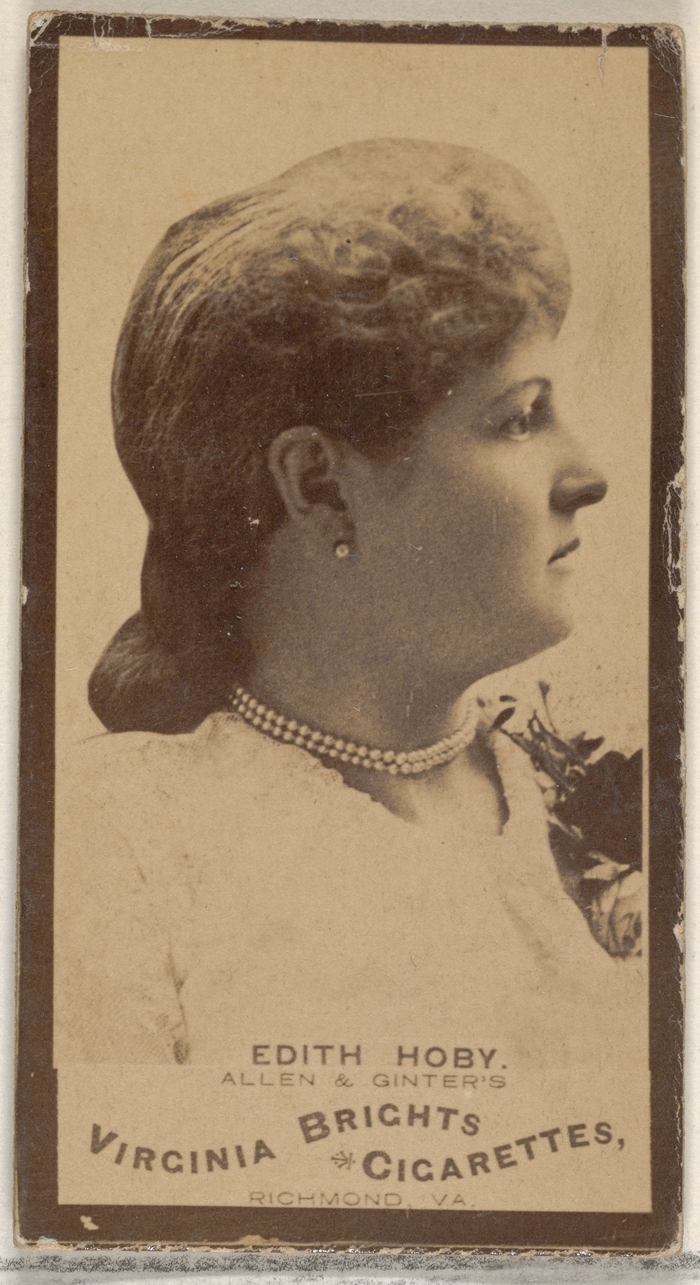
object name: photograph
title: Edith Hoby, from the Actors and Actresses series (N45, Type 3) for Virginia Brights Cigarettes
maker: allen & ginter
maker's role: publisher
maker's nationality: american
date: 1888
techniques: albumen silver print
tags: portraits,profiles,women,actresses